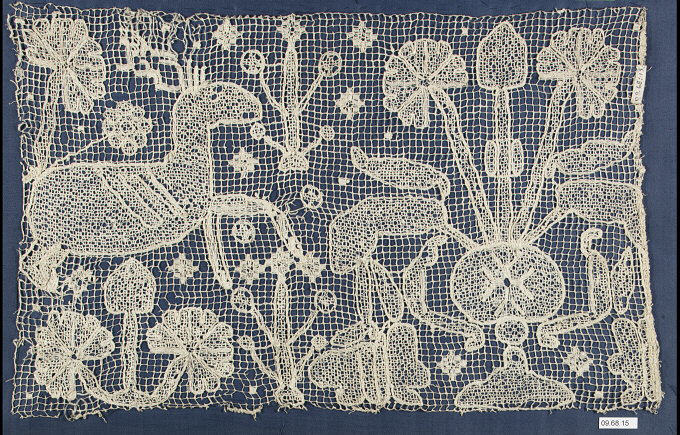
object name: fragment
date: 1501-1700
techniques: embroidery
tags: animals,flowers,leaves